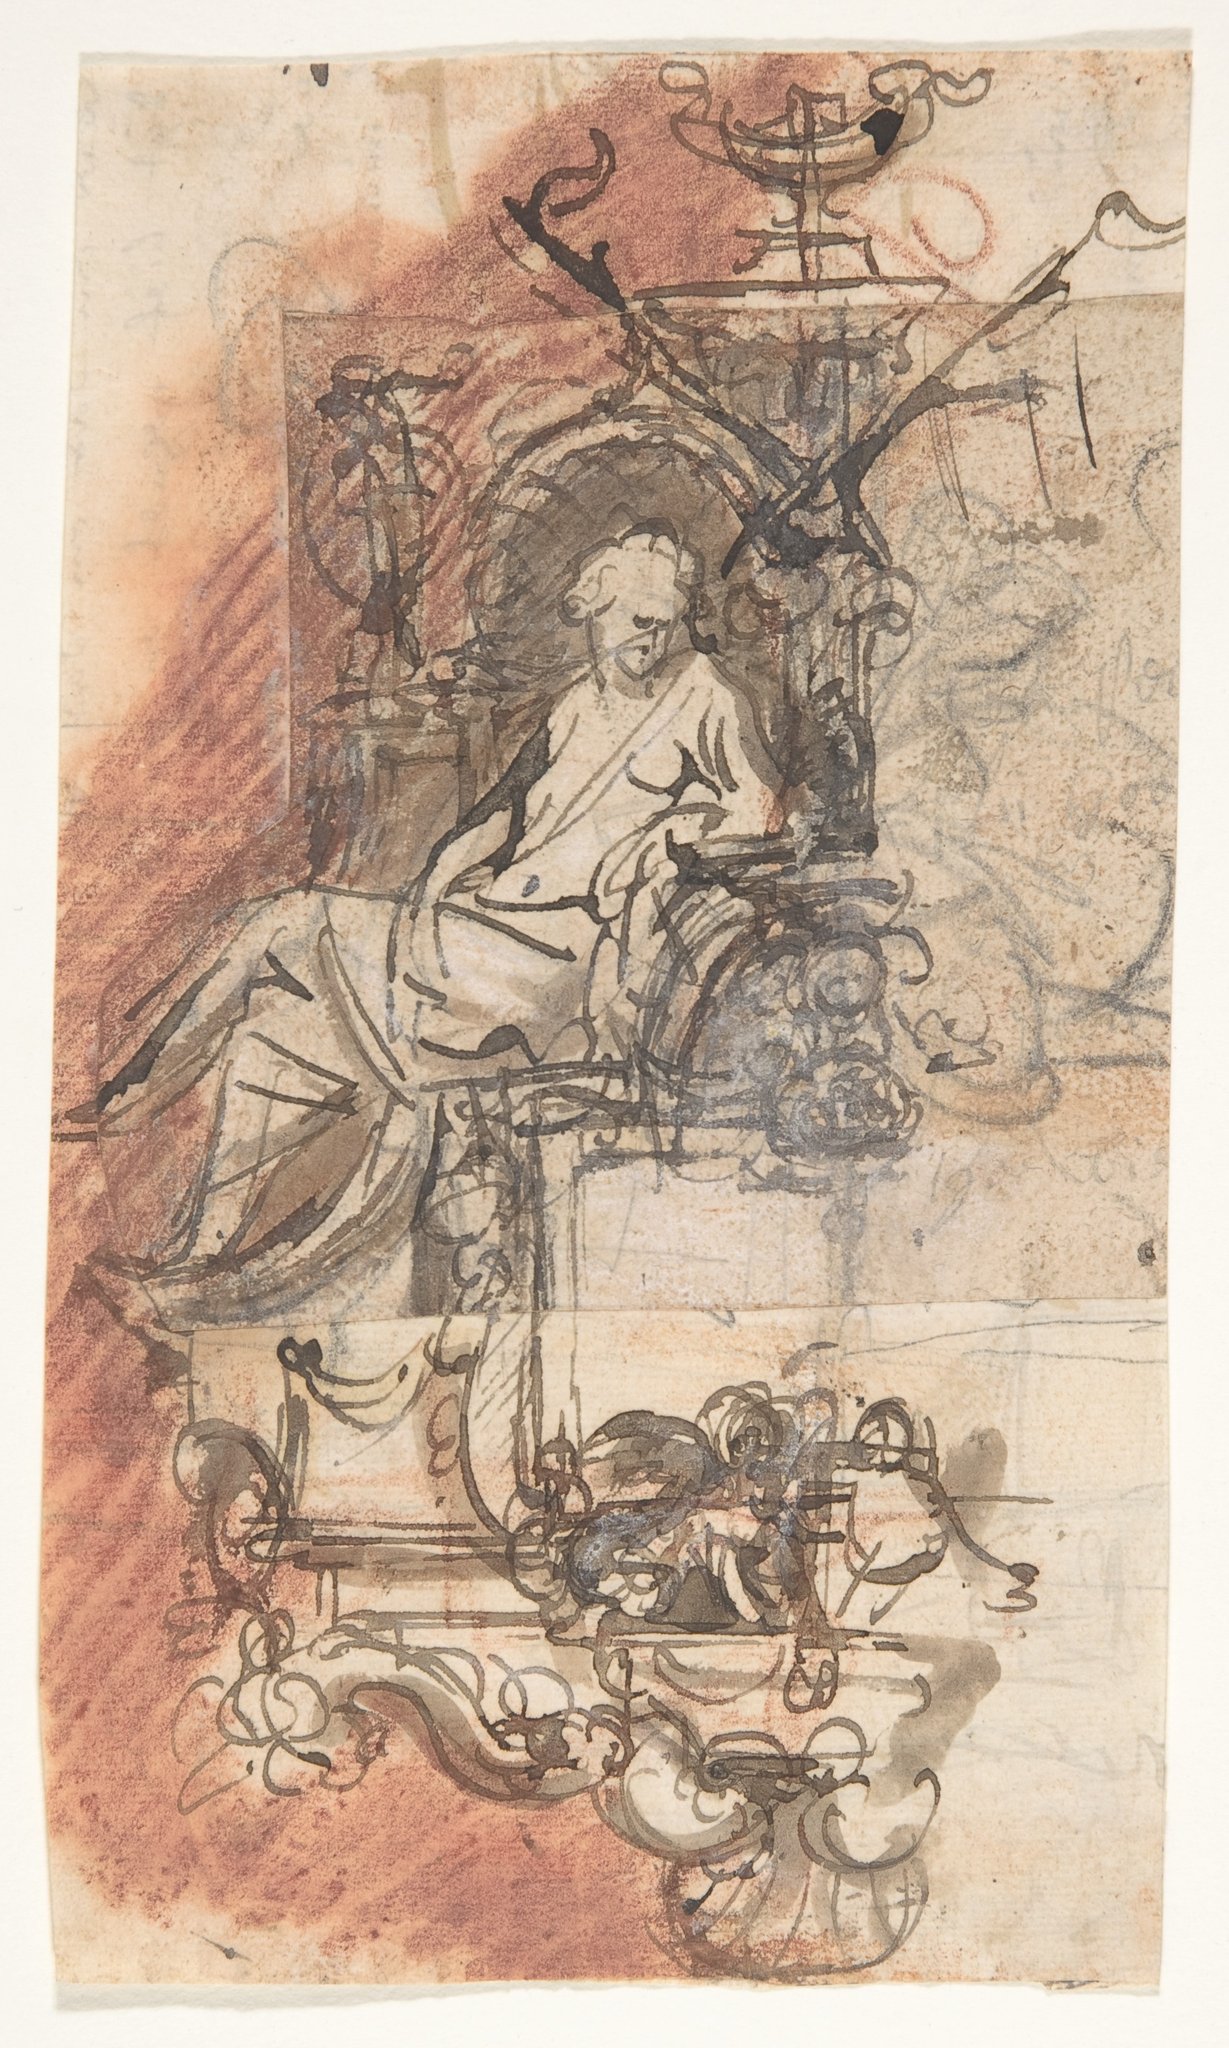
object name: drawing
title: Design for a sepulchral monument with a seated female figure (recto); Design for a statue of a standing male figure and fragment of a letter (verso)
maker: pieter verbruggen the younger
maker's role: artist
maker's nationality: flemish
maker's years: 1648-1691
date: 1667-1733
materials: chalk, gouache, graphite, ink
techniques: pen, wash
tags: architecture,men,women